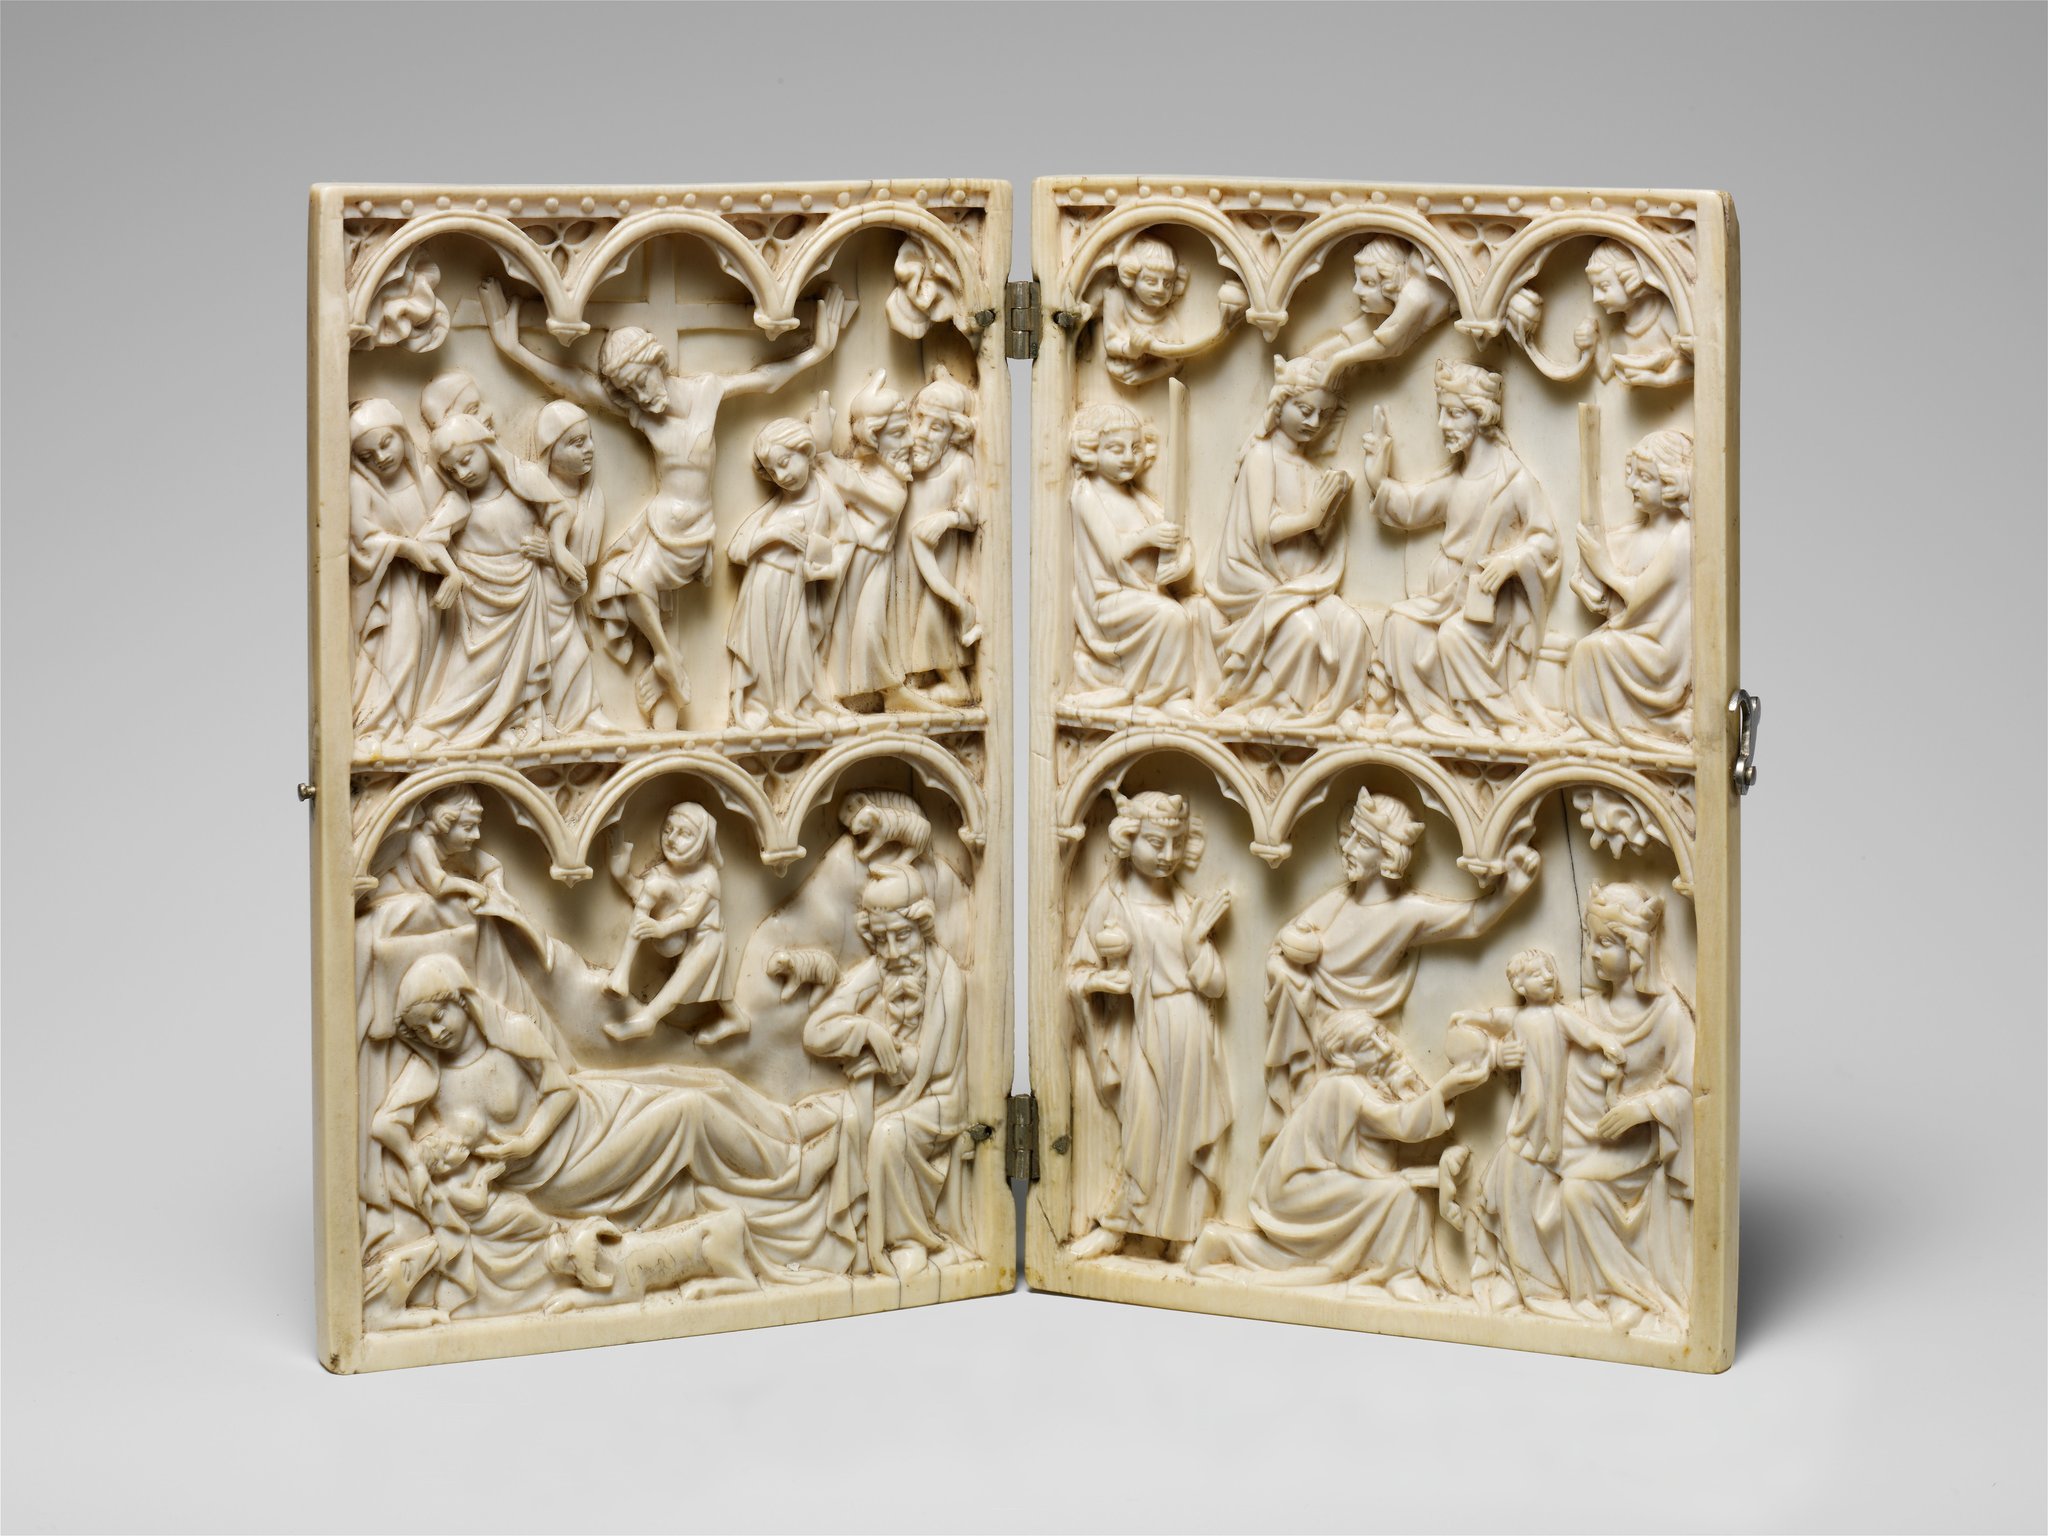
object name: diptych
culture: french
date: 1301-1400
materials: ivory, metal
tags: christ,virgin mary,adoration of the magi,crucifixion,saints